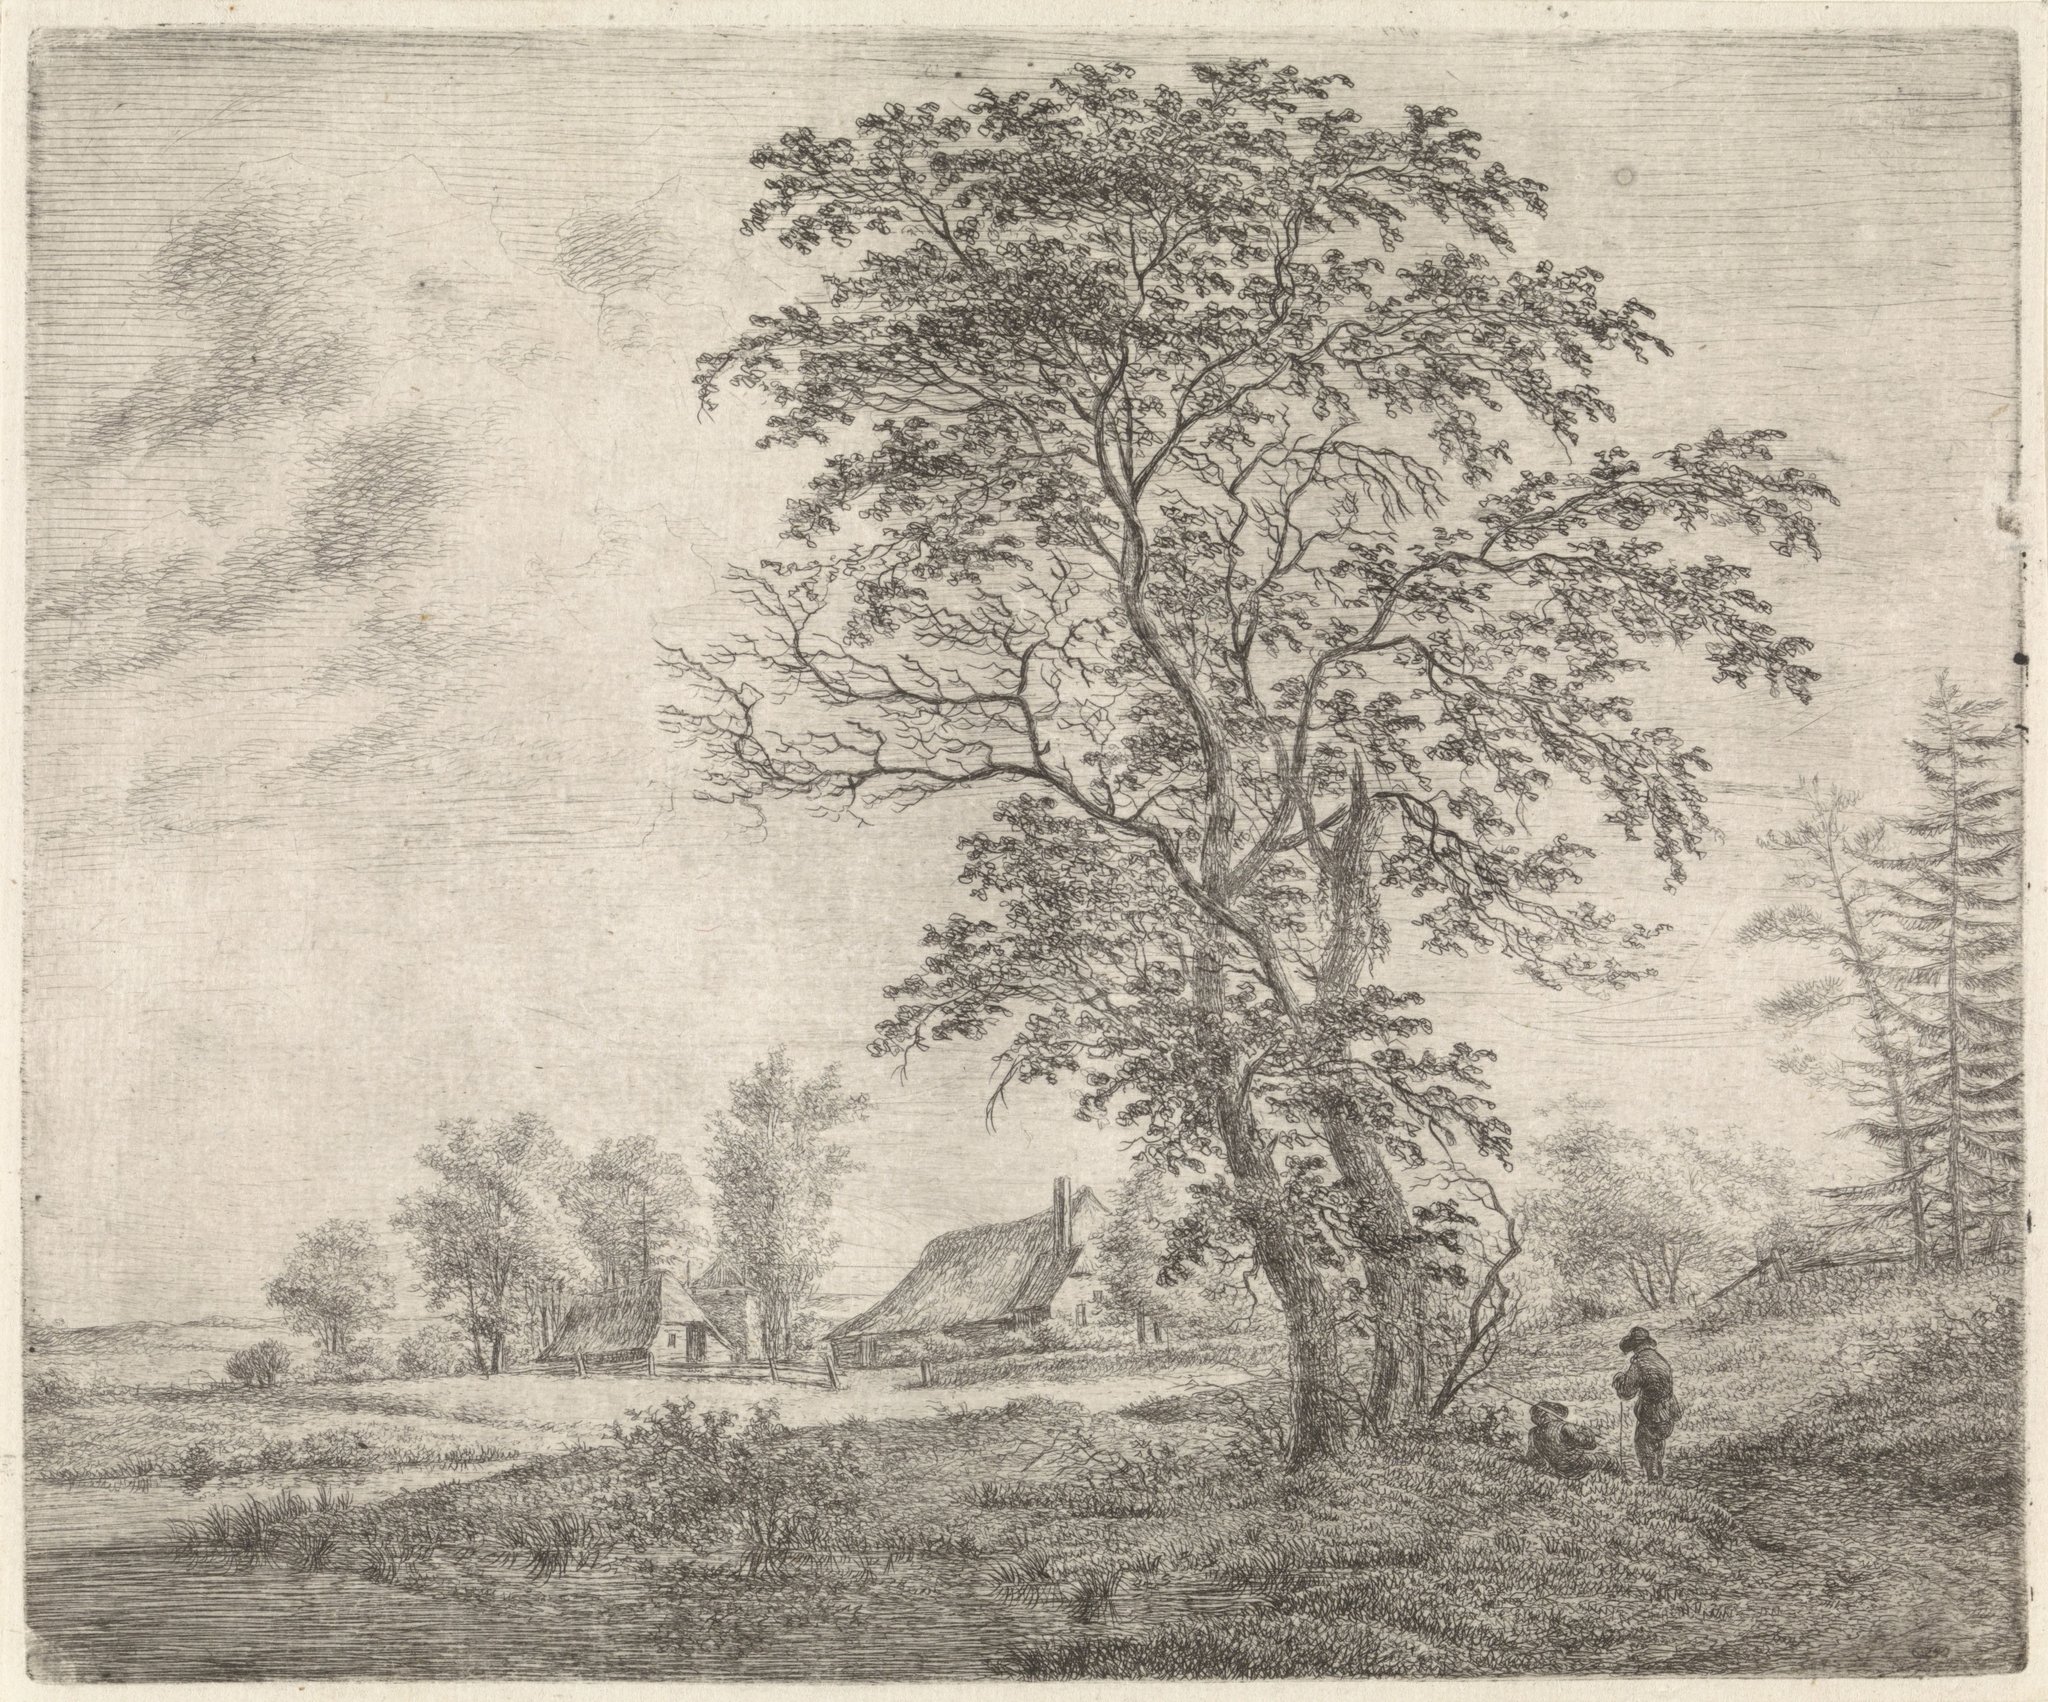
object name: print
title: Landschap met boerderij en twee figuren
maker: pieter janson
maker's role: draughtsman, print maker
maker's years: 1765-1851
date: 1780-1851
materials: paper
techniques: etching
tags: farm or solitary house in landscape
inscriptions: collector's mark: Lugt 2228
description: Landschap met een liggende figuur en een staande figuur, leunend op een stok, bij twee bomen. Op de achtergrond een boerderij.